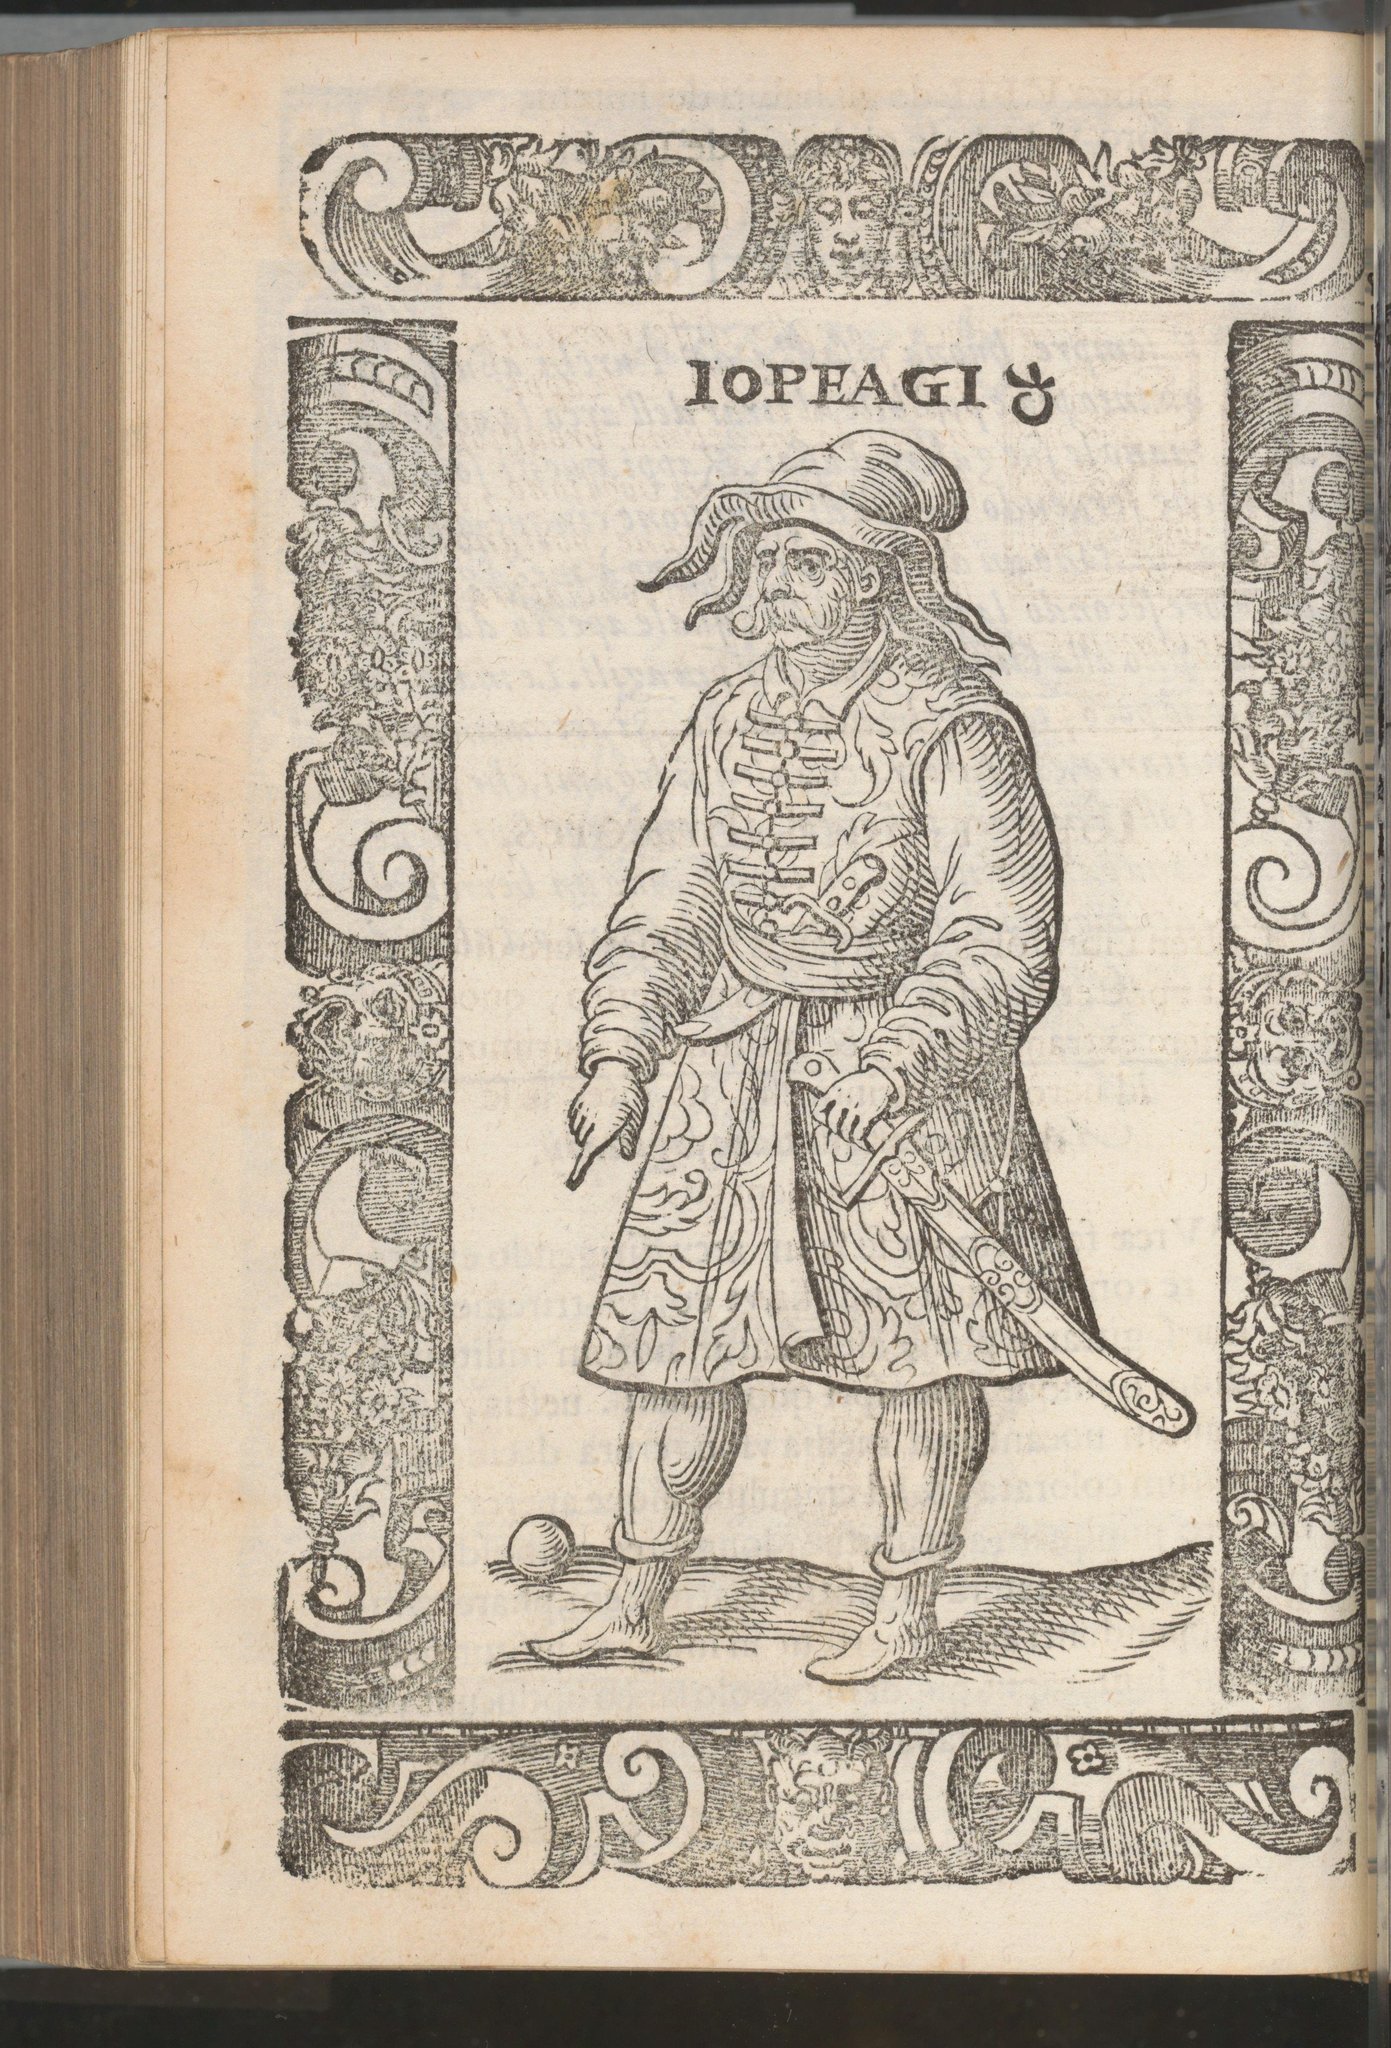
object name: costume print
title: Habiti antichi, et moderni di tutto il mondo...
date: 1598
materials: paper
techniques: woodcut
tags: fashion plates